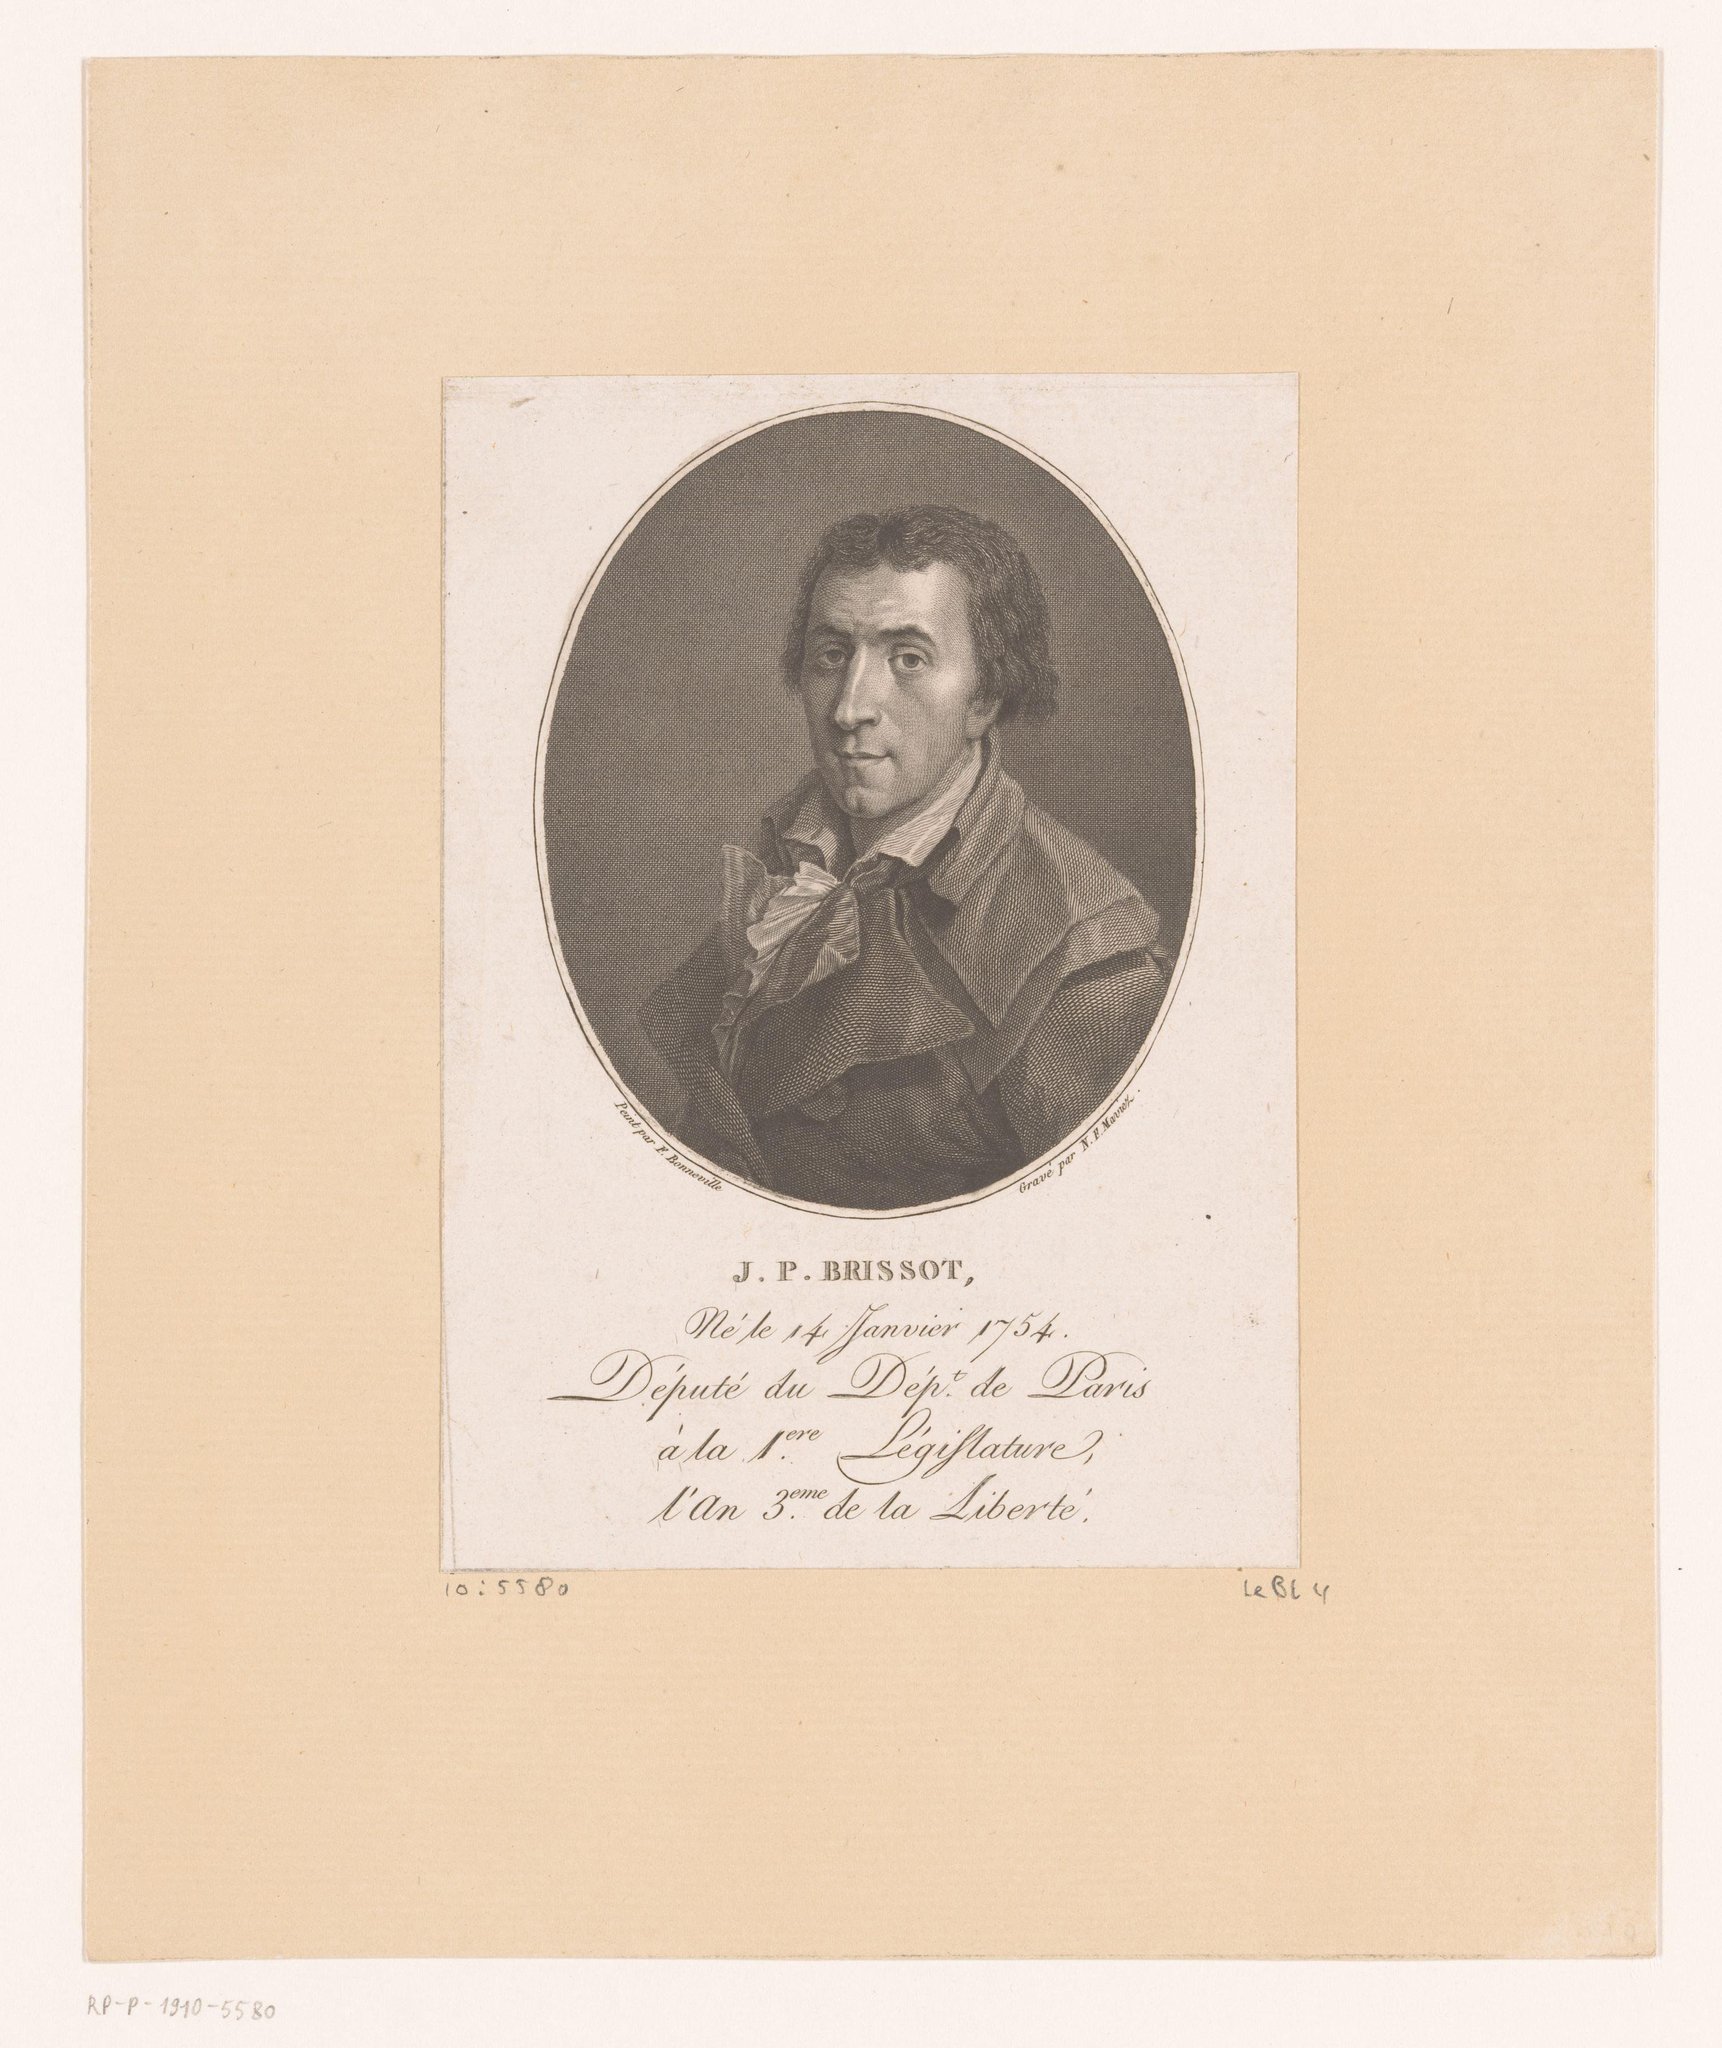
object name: print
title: Portret van Jacques Pierre Brissot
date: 1795-1805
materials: paper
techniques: engraving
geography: france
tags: paris, politician, journalist, reporter, historical persons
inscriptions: collector's mark: Lugt 2228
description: Bij de prent wordt een handgeschreven biografie van Brissot bewaard op de achterzijde.